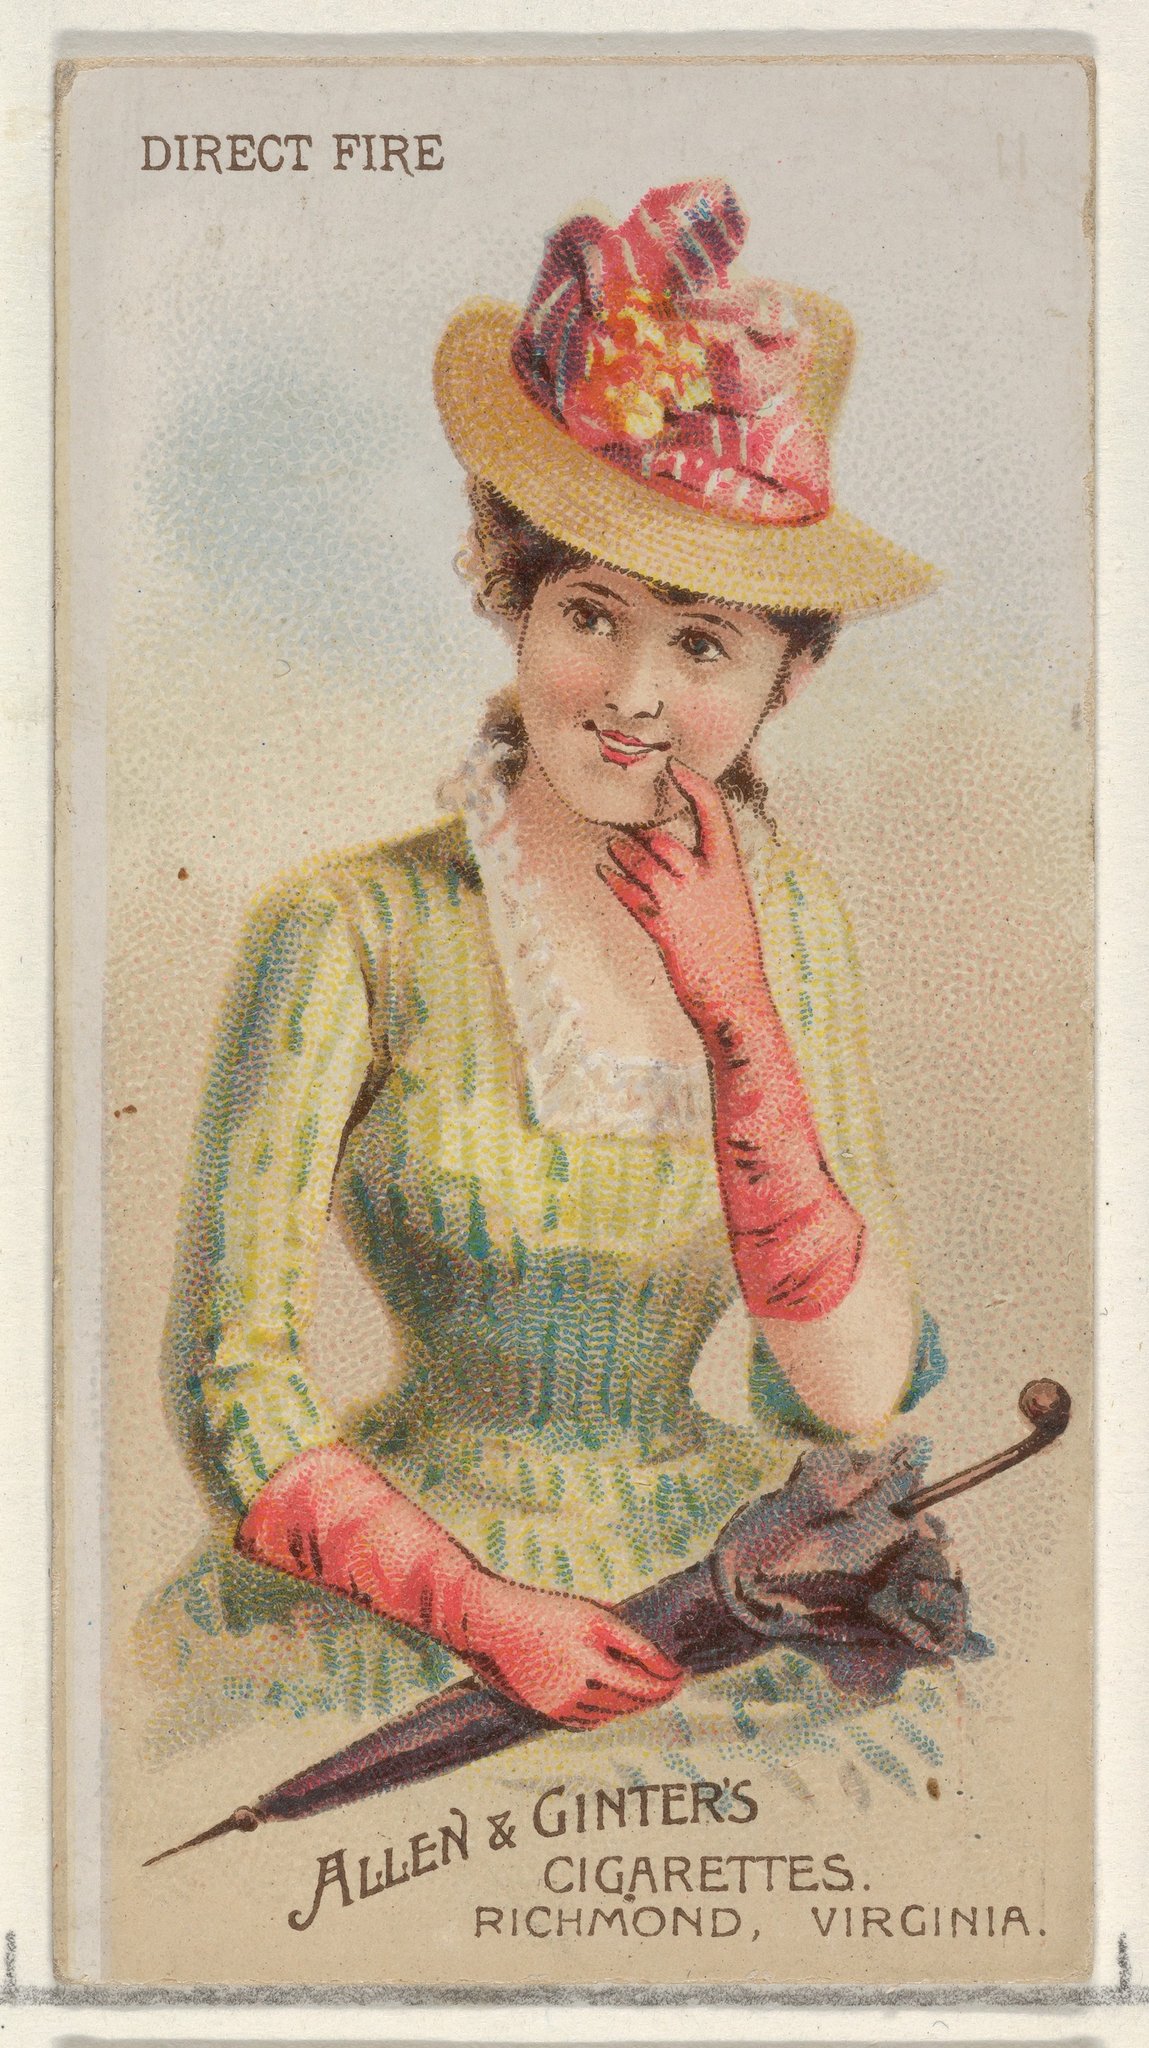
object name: print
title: Direct Fire, from the Parasol Drills series (N18) for Allen & Ginter Cigarettes Brands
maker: allen & ginter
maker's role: publisher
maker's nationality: american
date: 1888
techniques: color lithograph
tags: women